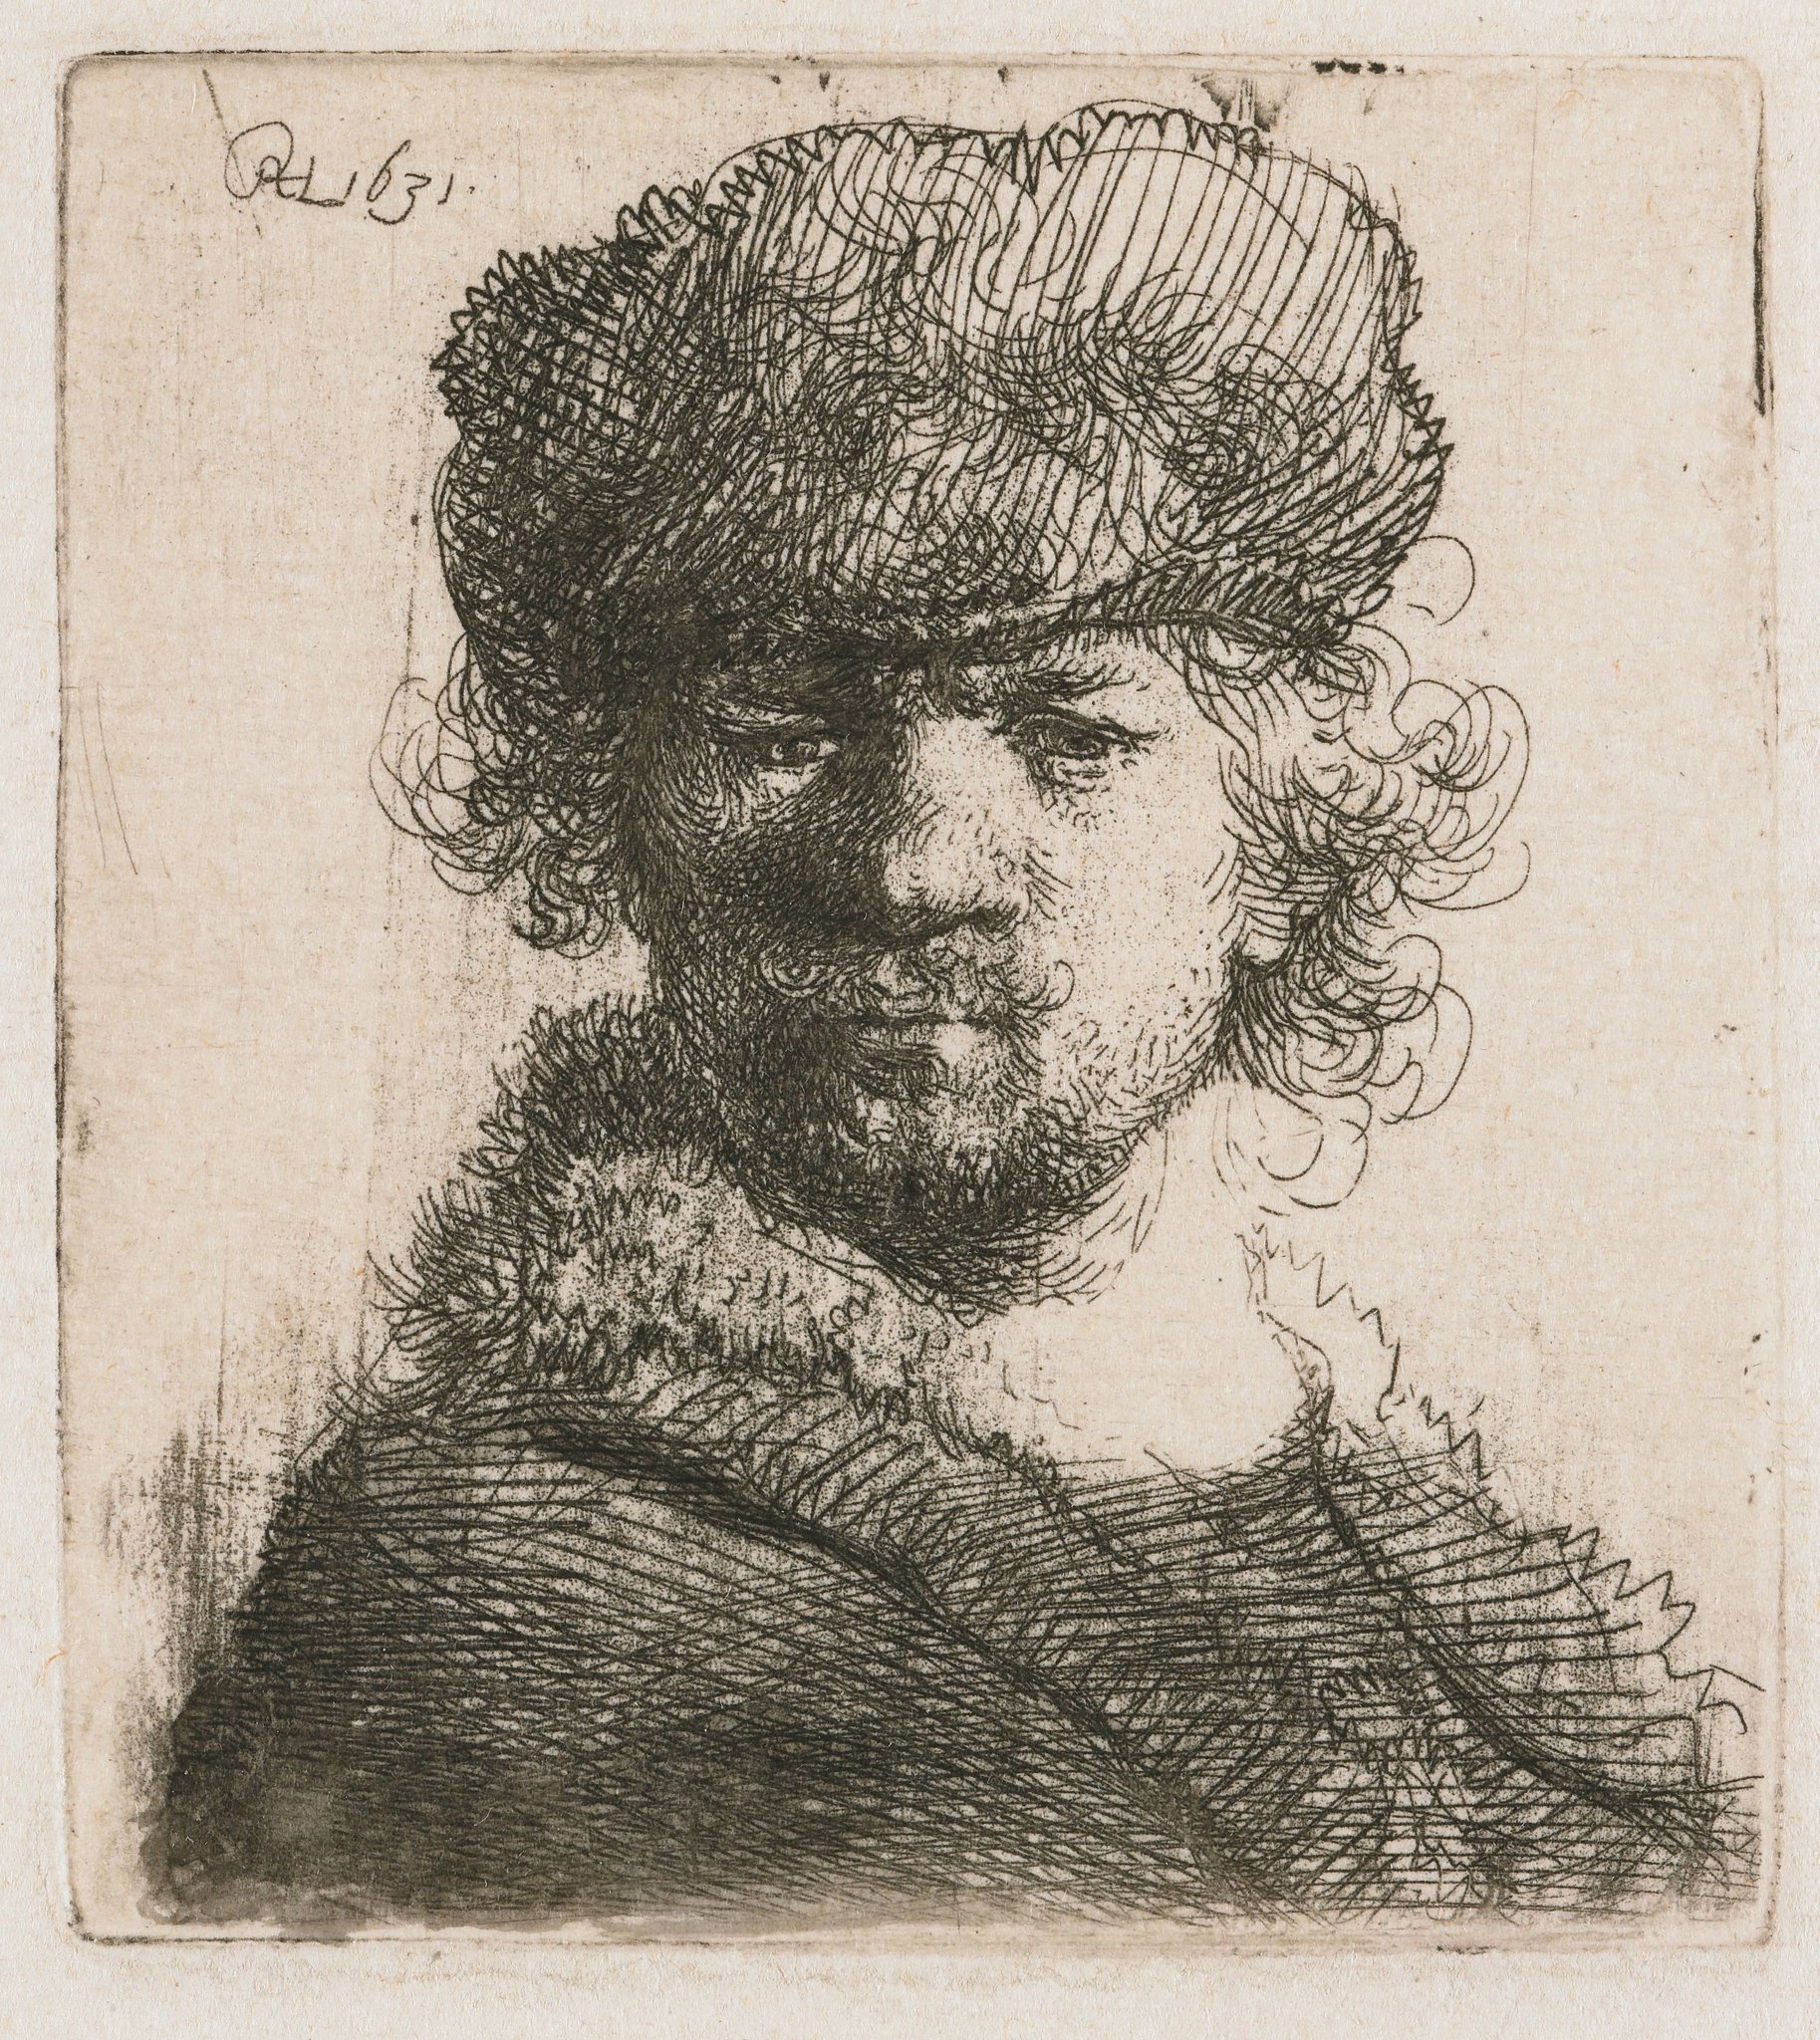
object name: print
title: Self-portrait in a Heavy Fur Cap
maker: rembrandt van rijn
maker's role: draughtsman, painter, print maker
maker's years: 1606-1669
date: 1631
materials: paper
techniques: etching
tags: leiden, amsterdam, painter, print maker, draughtsman, rembrandt van rijn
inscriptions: collector's mark: Lugt 240, monogram and date: ‘RHL 1631’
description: Rembrandt was fascinated by the effects of light. This is also clear in his etchings, for instance in these diminutive self-portraits in which his face is mostly half cast in shadow. In the version with a fur cap, we can see that this head covering was added only at a later stage. He began the etching with a bare head: his hair is still visible through the cap.